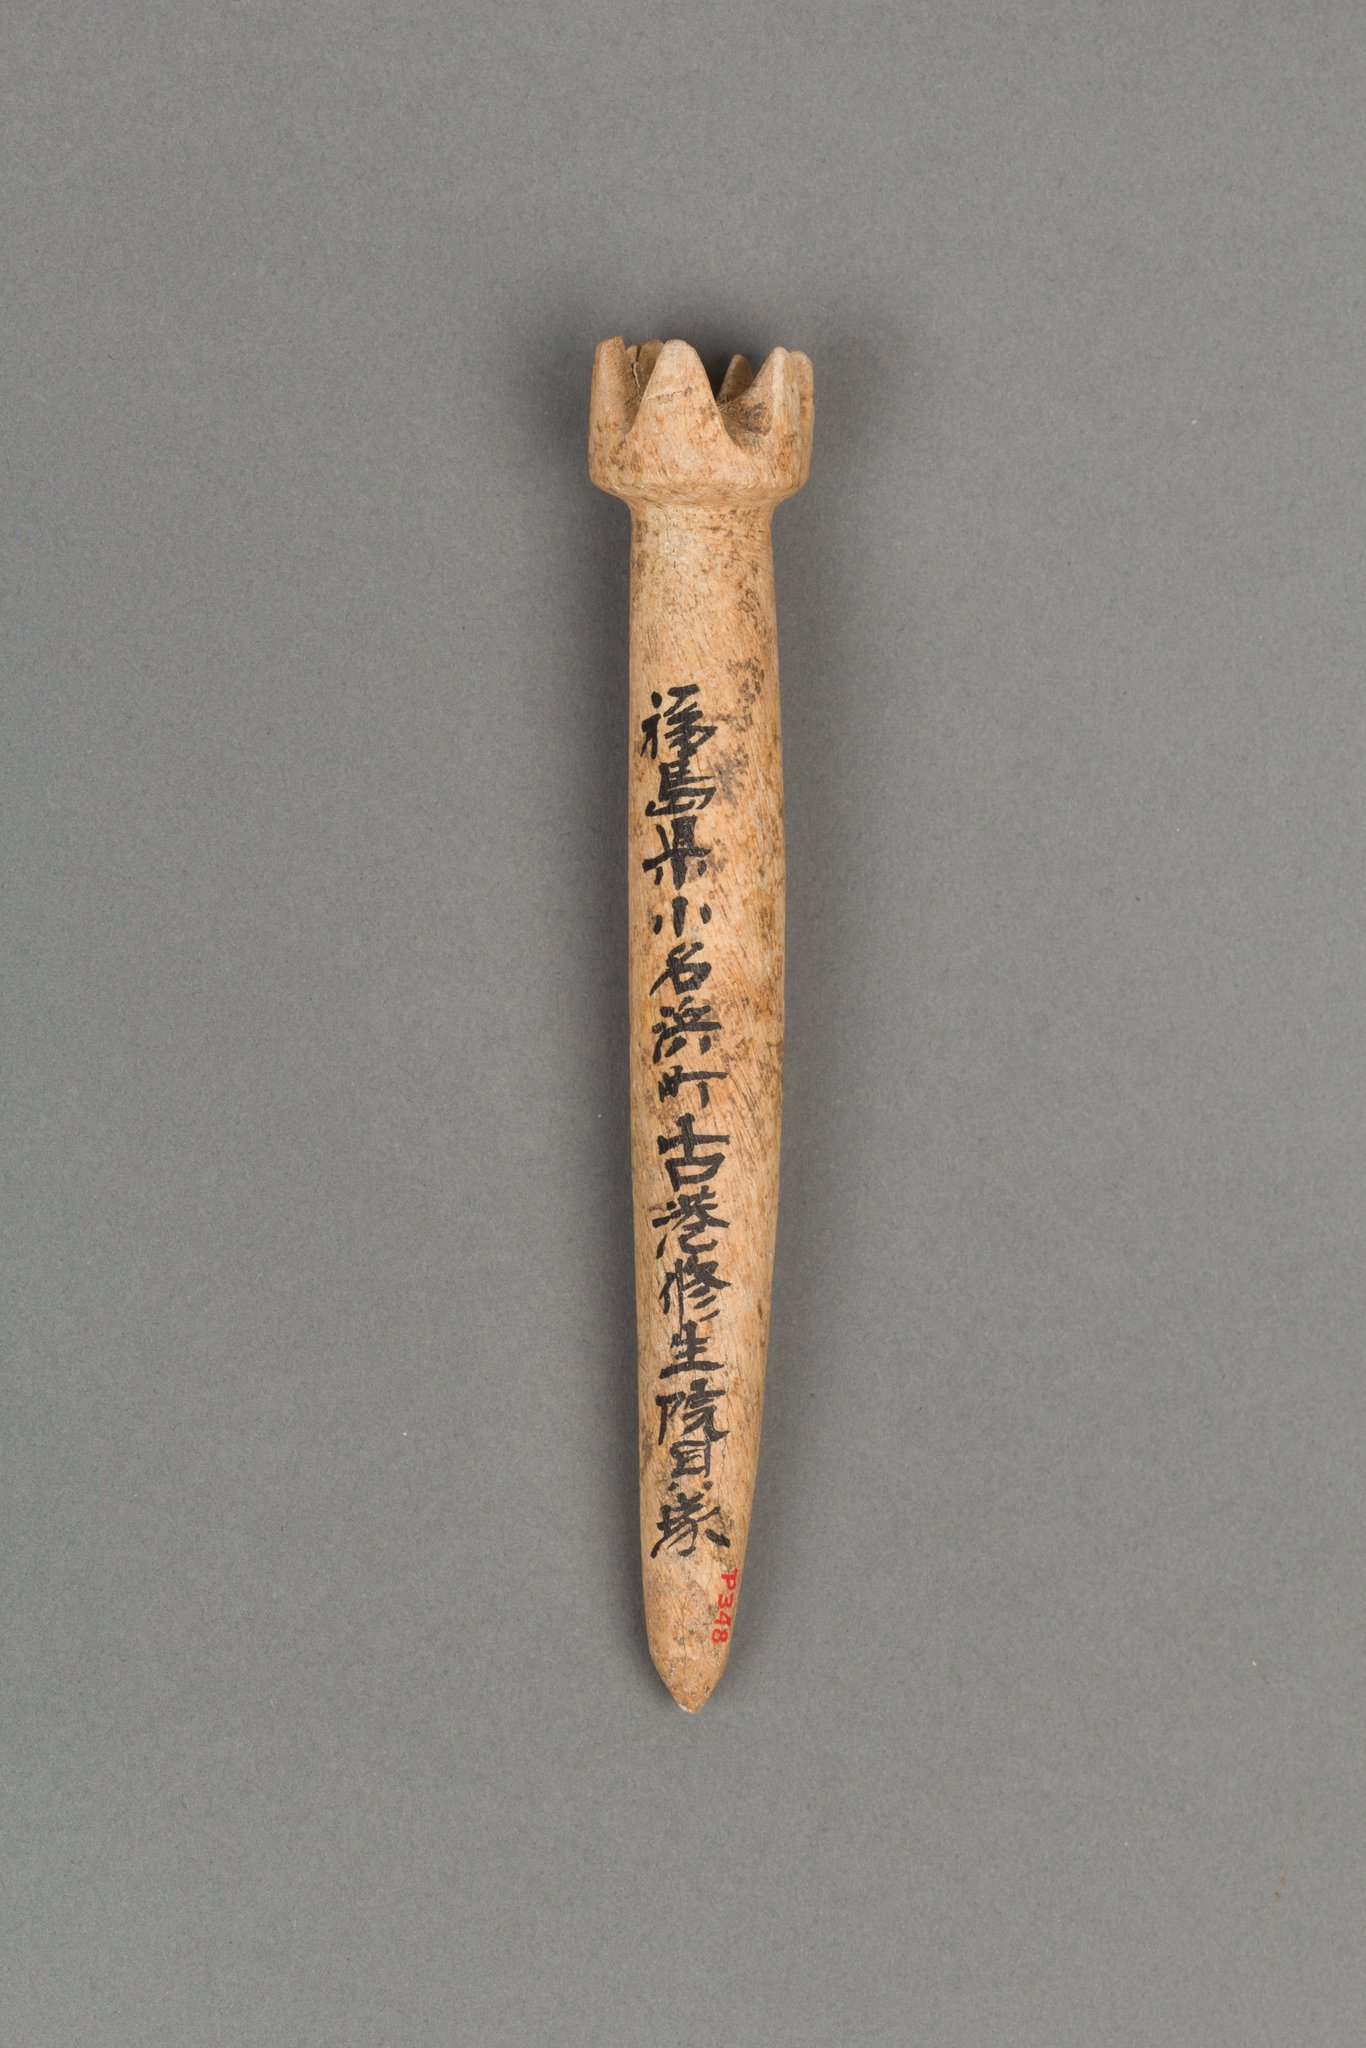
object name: body ornament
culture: japanese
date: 1200-200 BCE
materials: bone